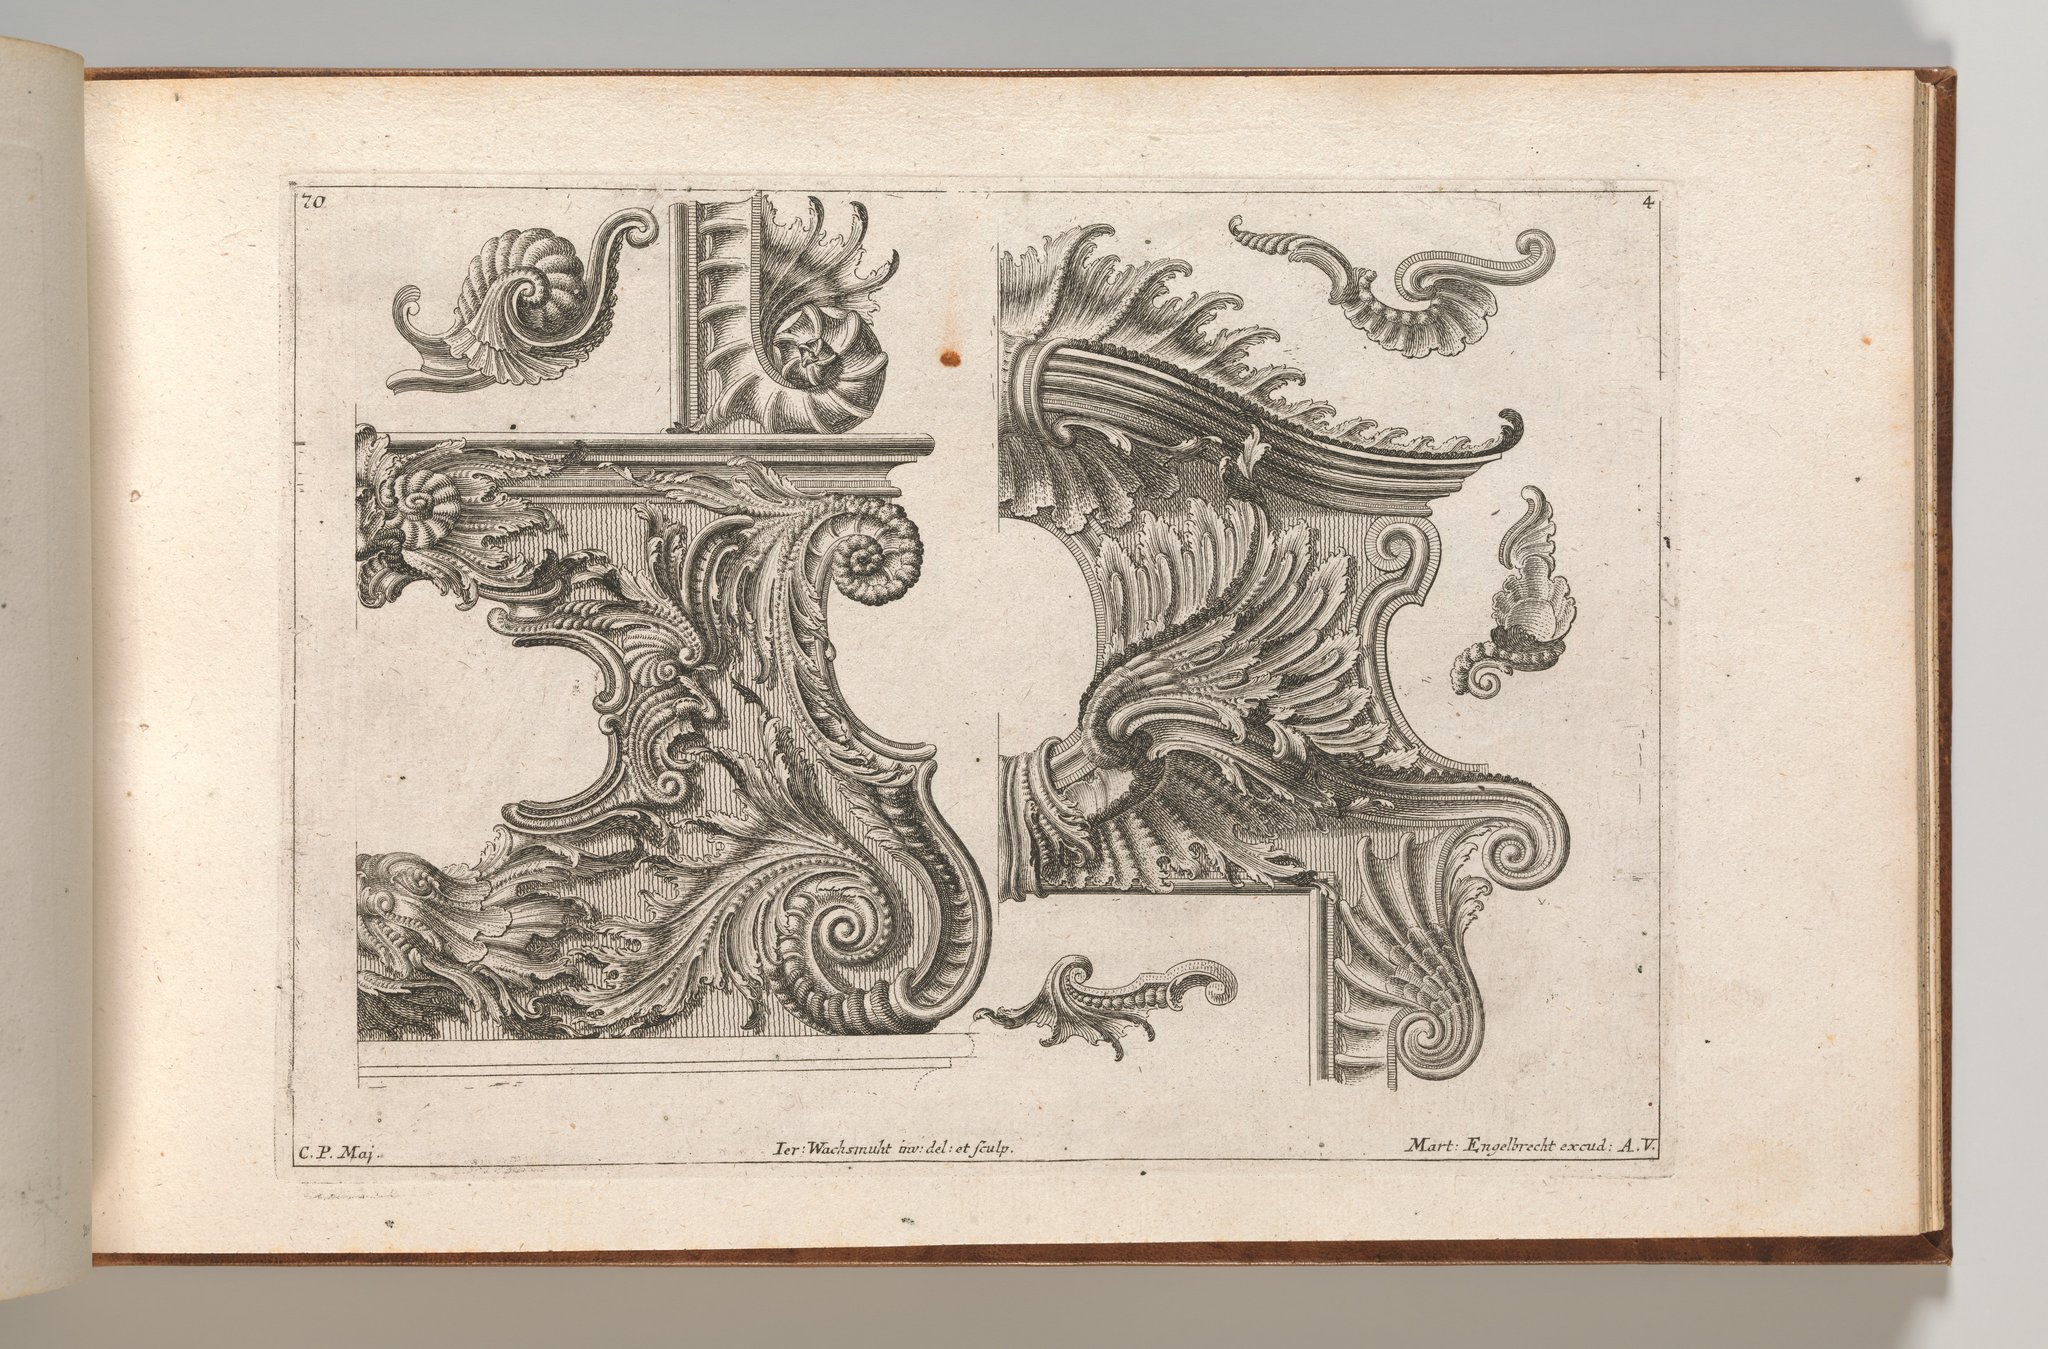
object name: album print ornament architecture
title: Suggestion for the Decoration of the Lower and Top Right of a Frame, Plate 4 from: 'Unterschidliche Auszierungen zu Thüren und Fenster, etc. etc. sehr nutzlich zu gebrauchen'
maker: jeremias wachsmuth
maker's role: artist and engraver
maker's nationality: german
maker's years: 1712-1771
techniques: etching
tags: ornament